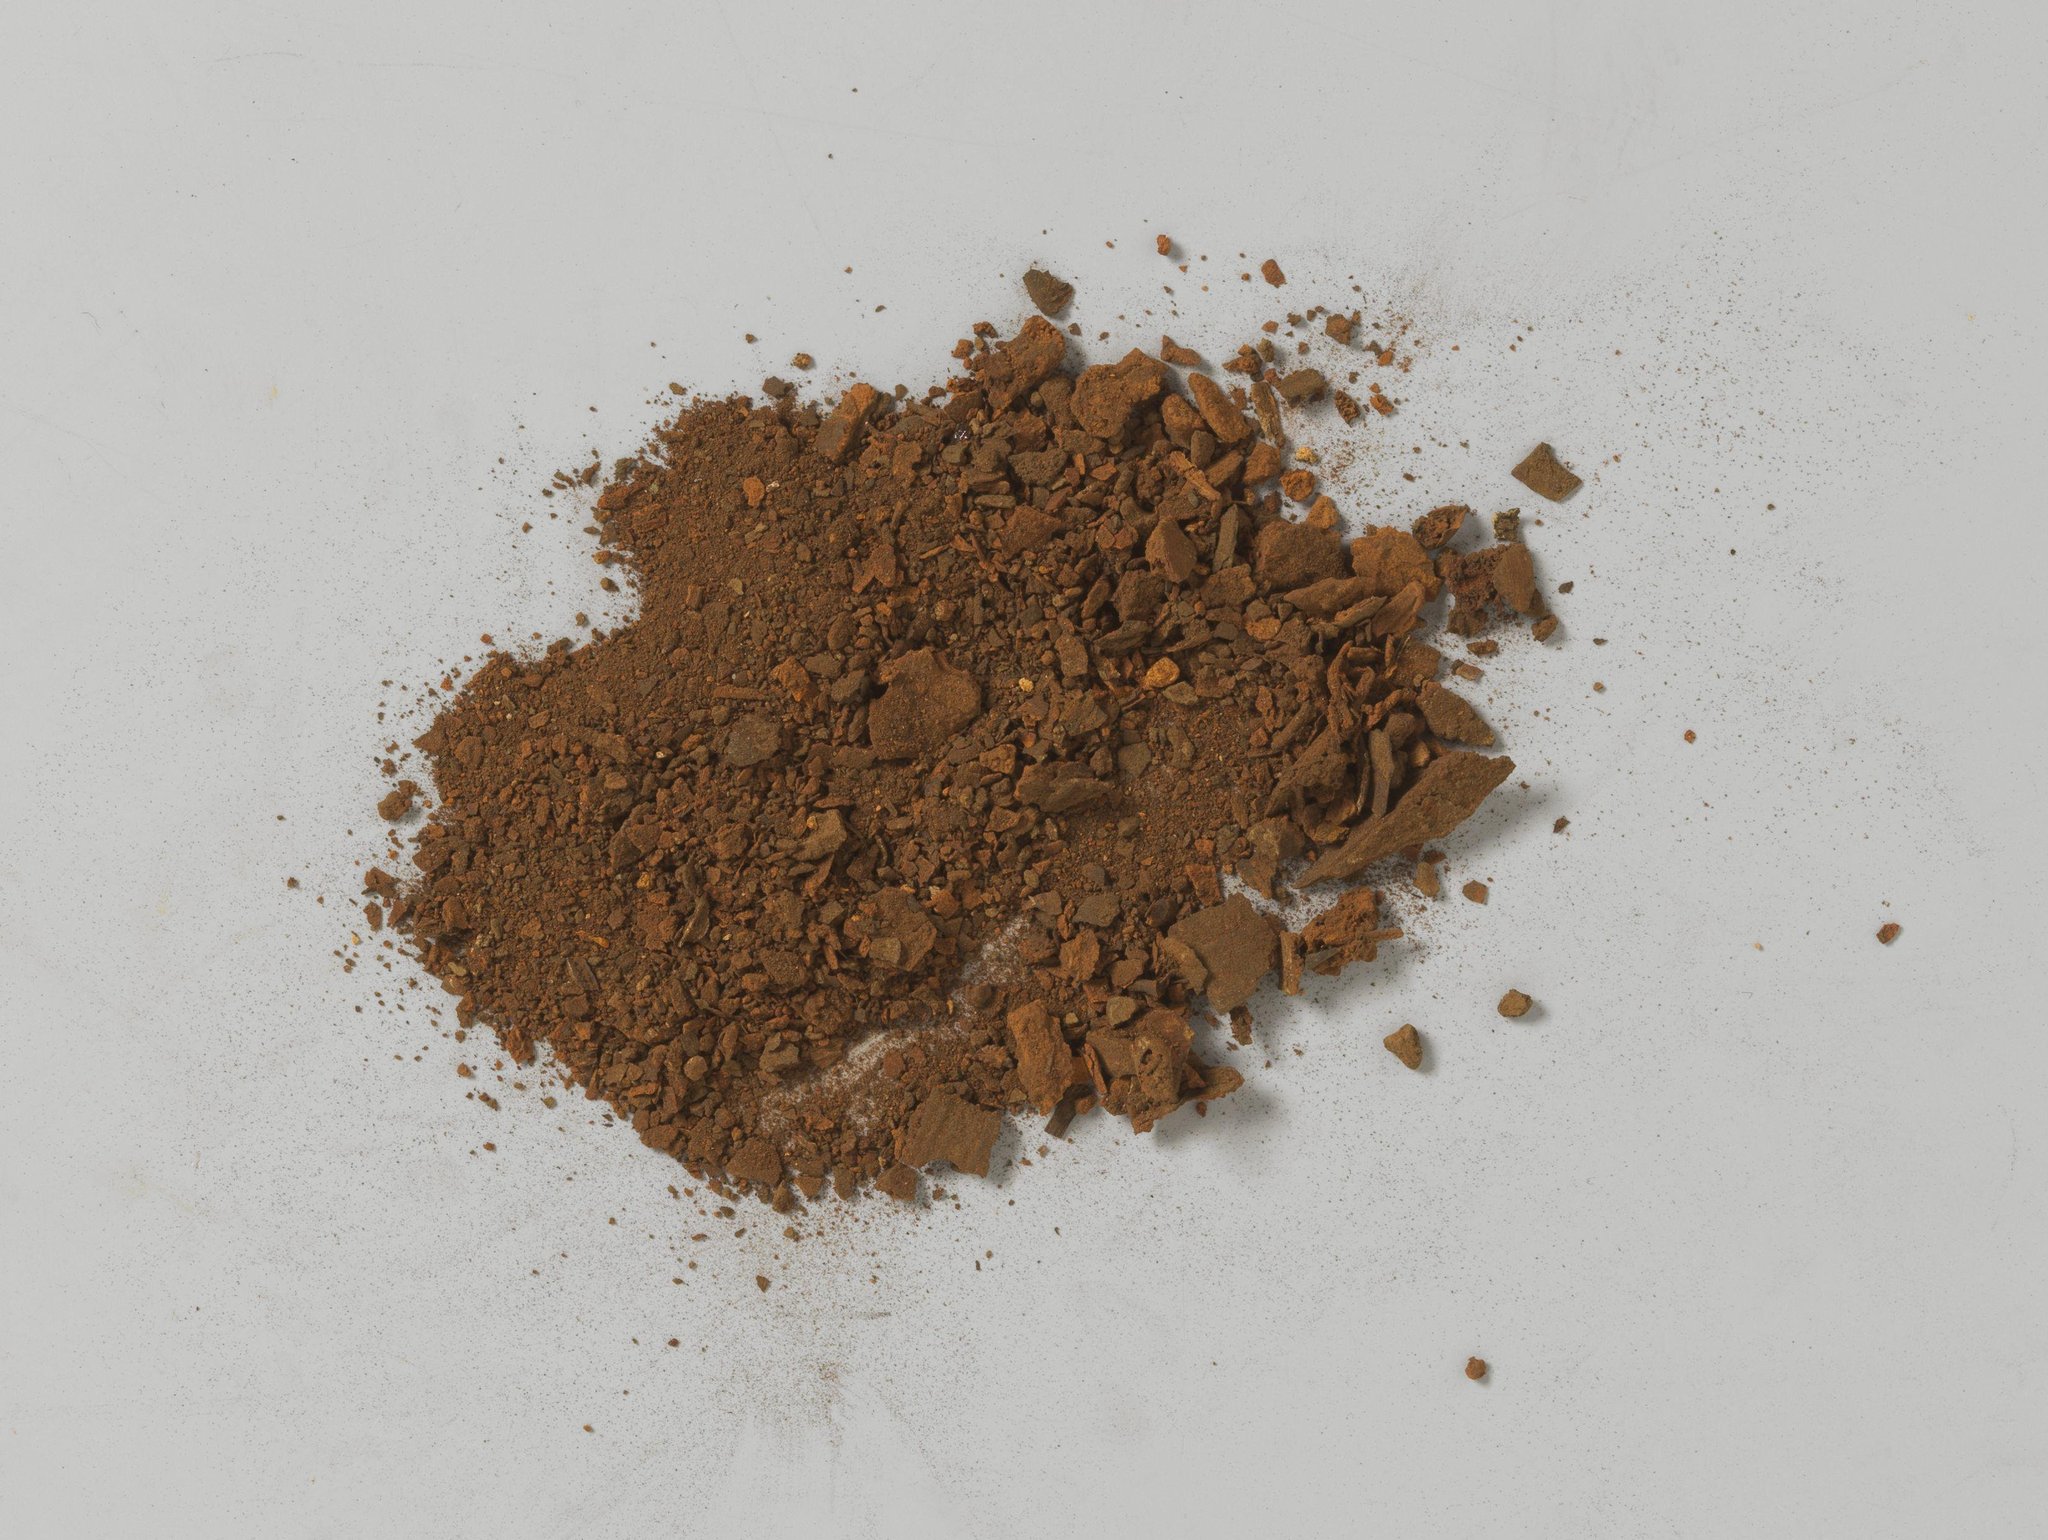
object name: sample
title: Monster uit het wrak van de Oostindiëvaarder Hollandia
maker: Anonymous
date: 1700-1743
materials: organic material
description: Monster overblijfselen na zeven van vat H44.